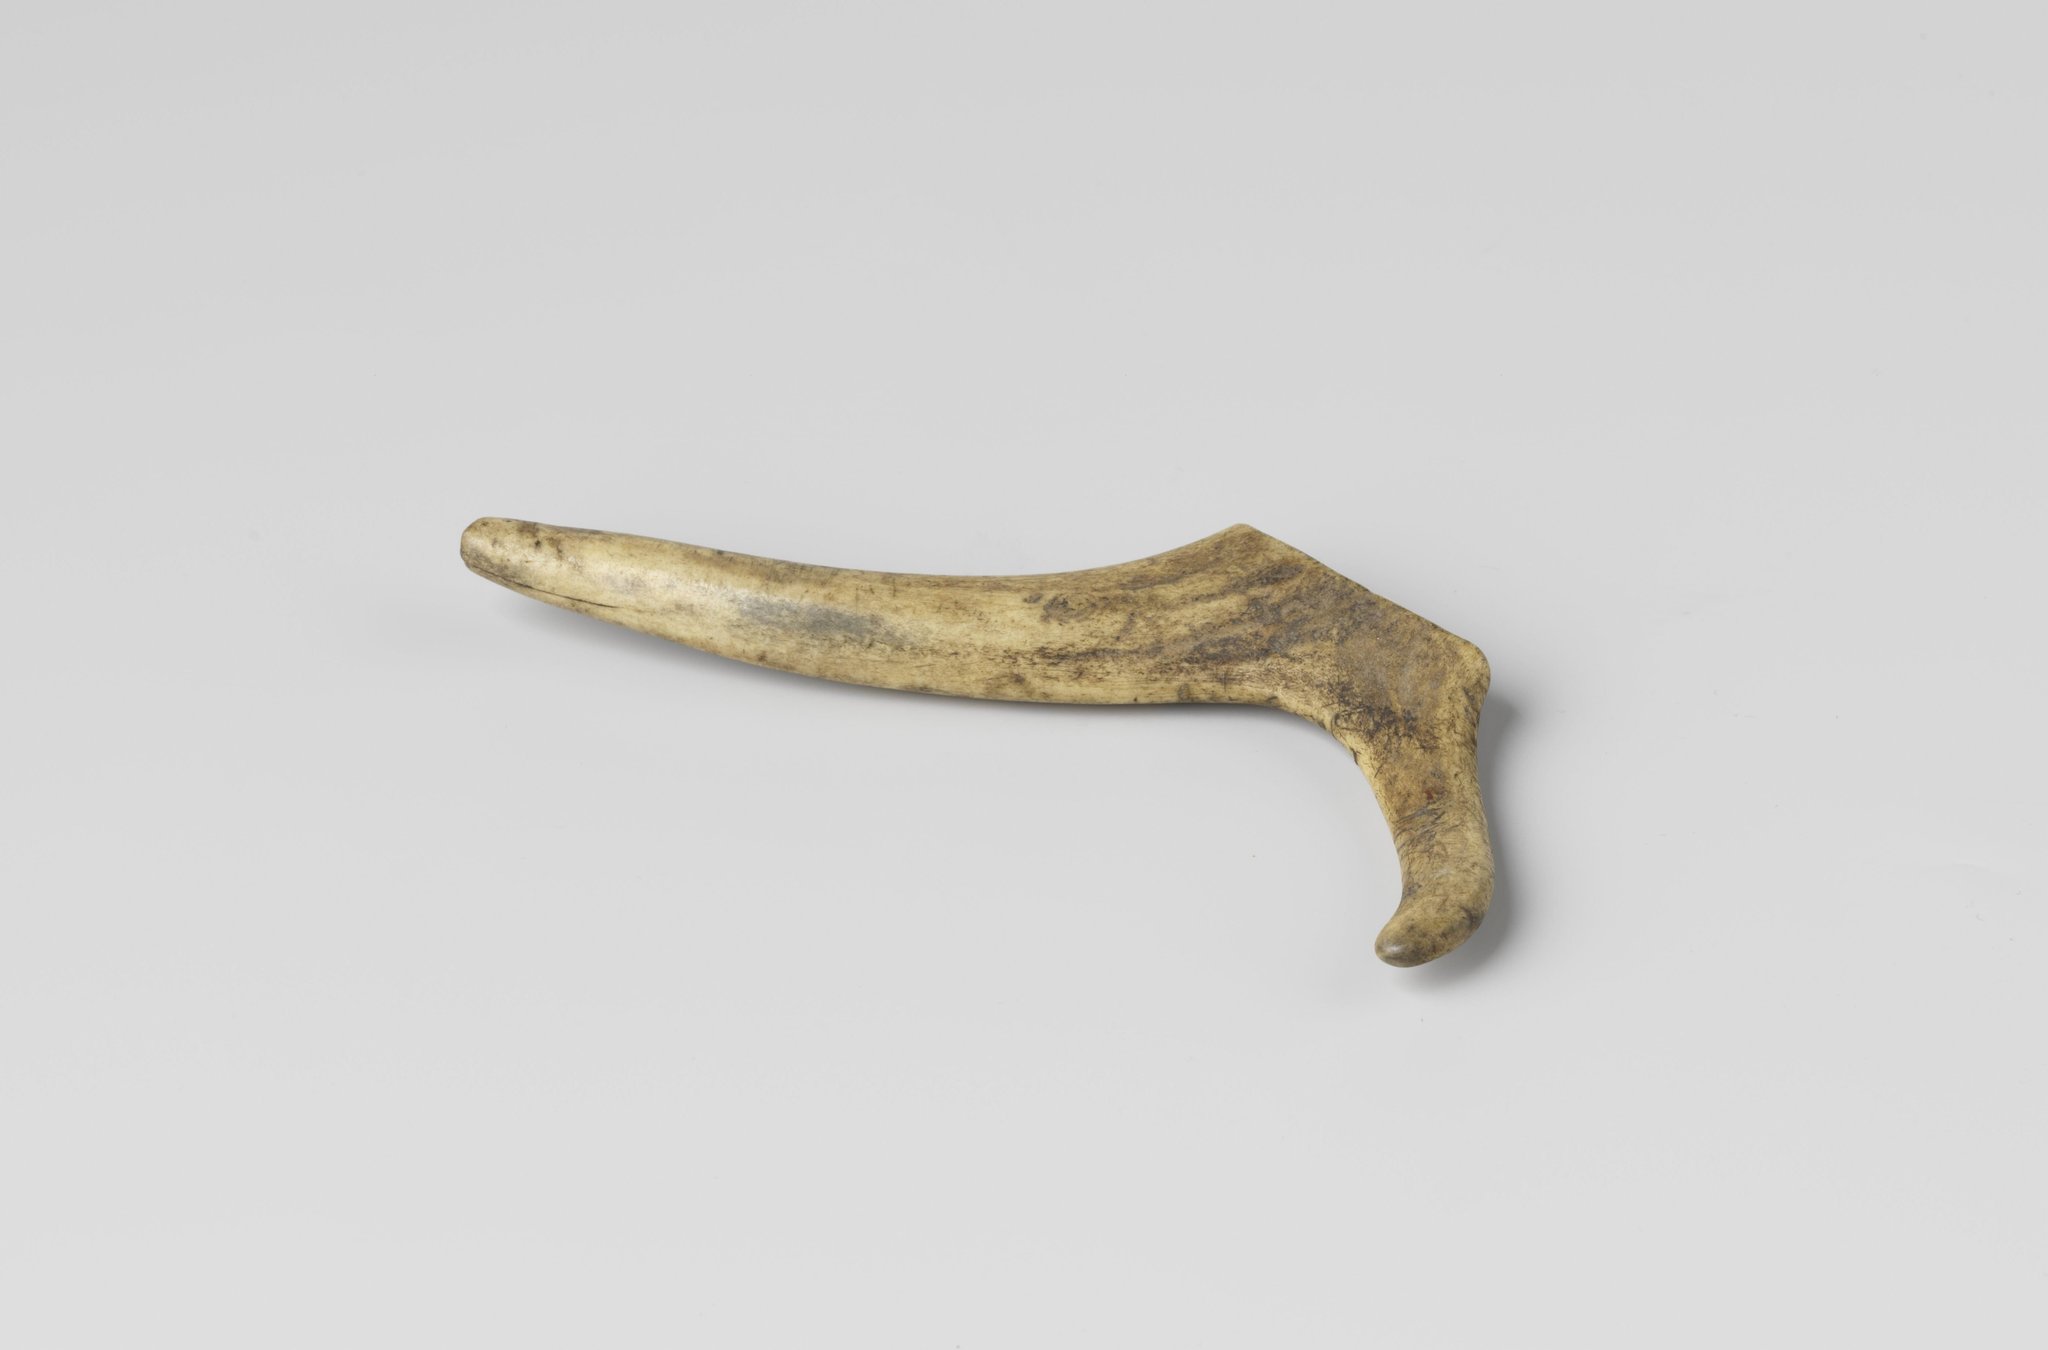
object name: hertengewei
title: Stang van een gewei van een ree, gevonden in 1724 bij werkzaamheden in de Hillegommerbeek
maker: Anonymous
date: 1724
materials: horn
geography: netherlands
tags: hillegom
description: Behorend tot drie hertshoornen en twee slagtanden van een wild zwijn (NG-NM-1392-1 t/m NG-NM-1392-5).